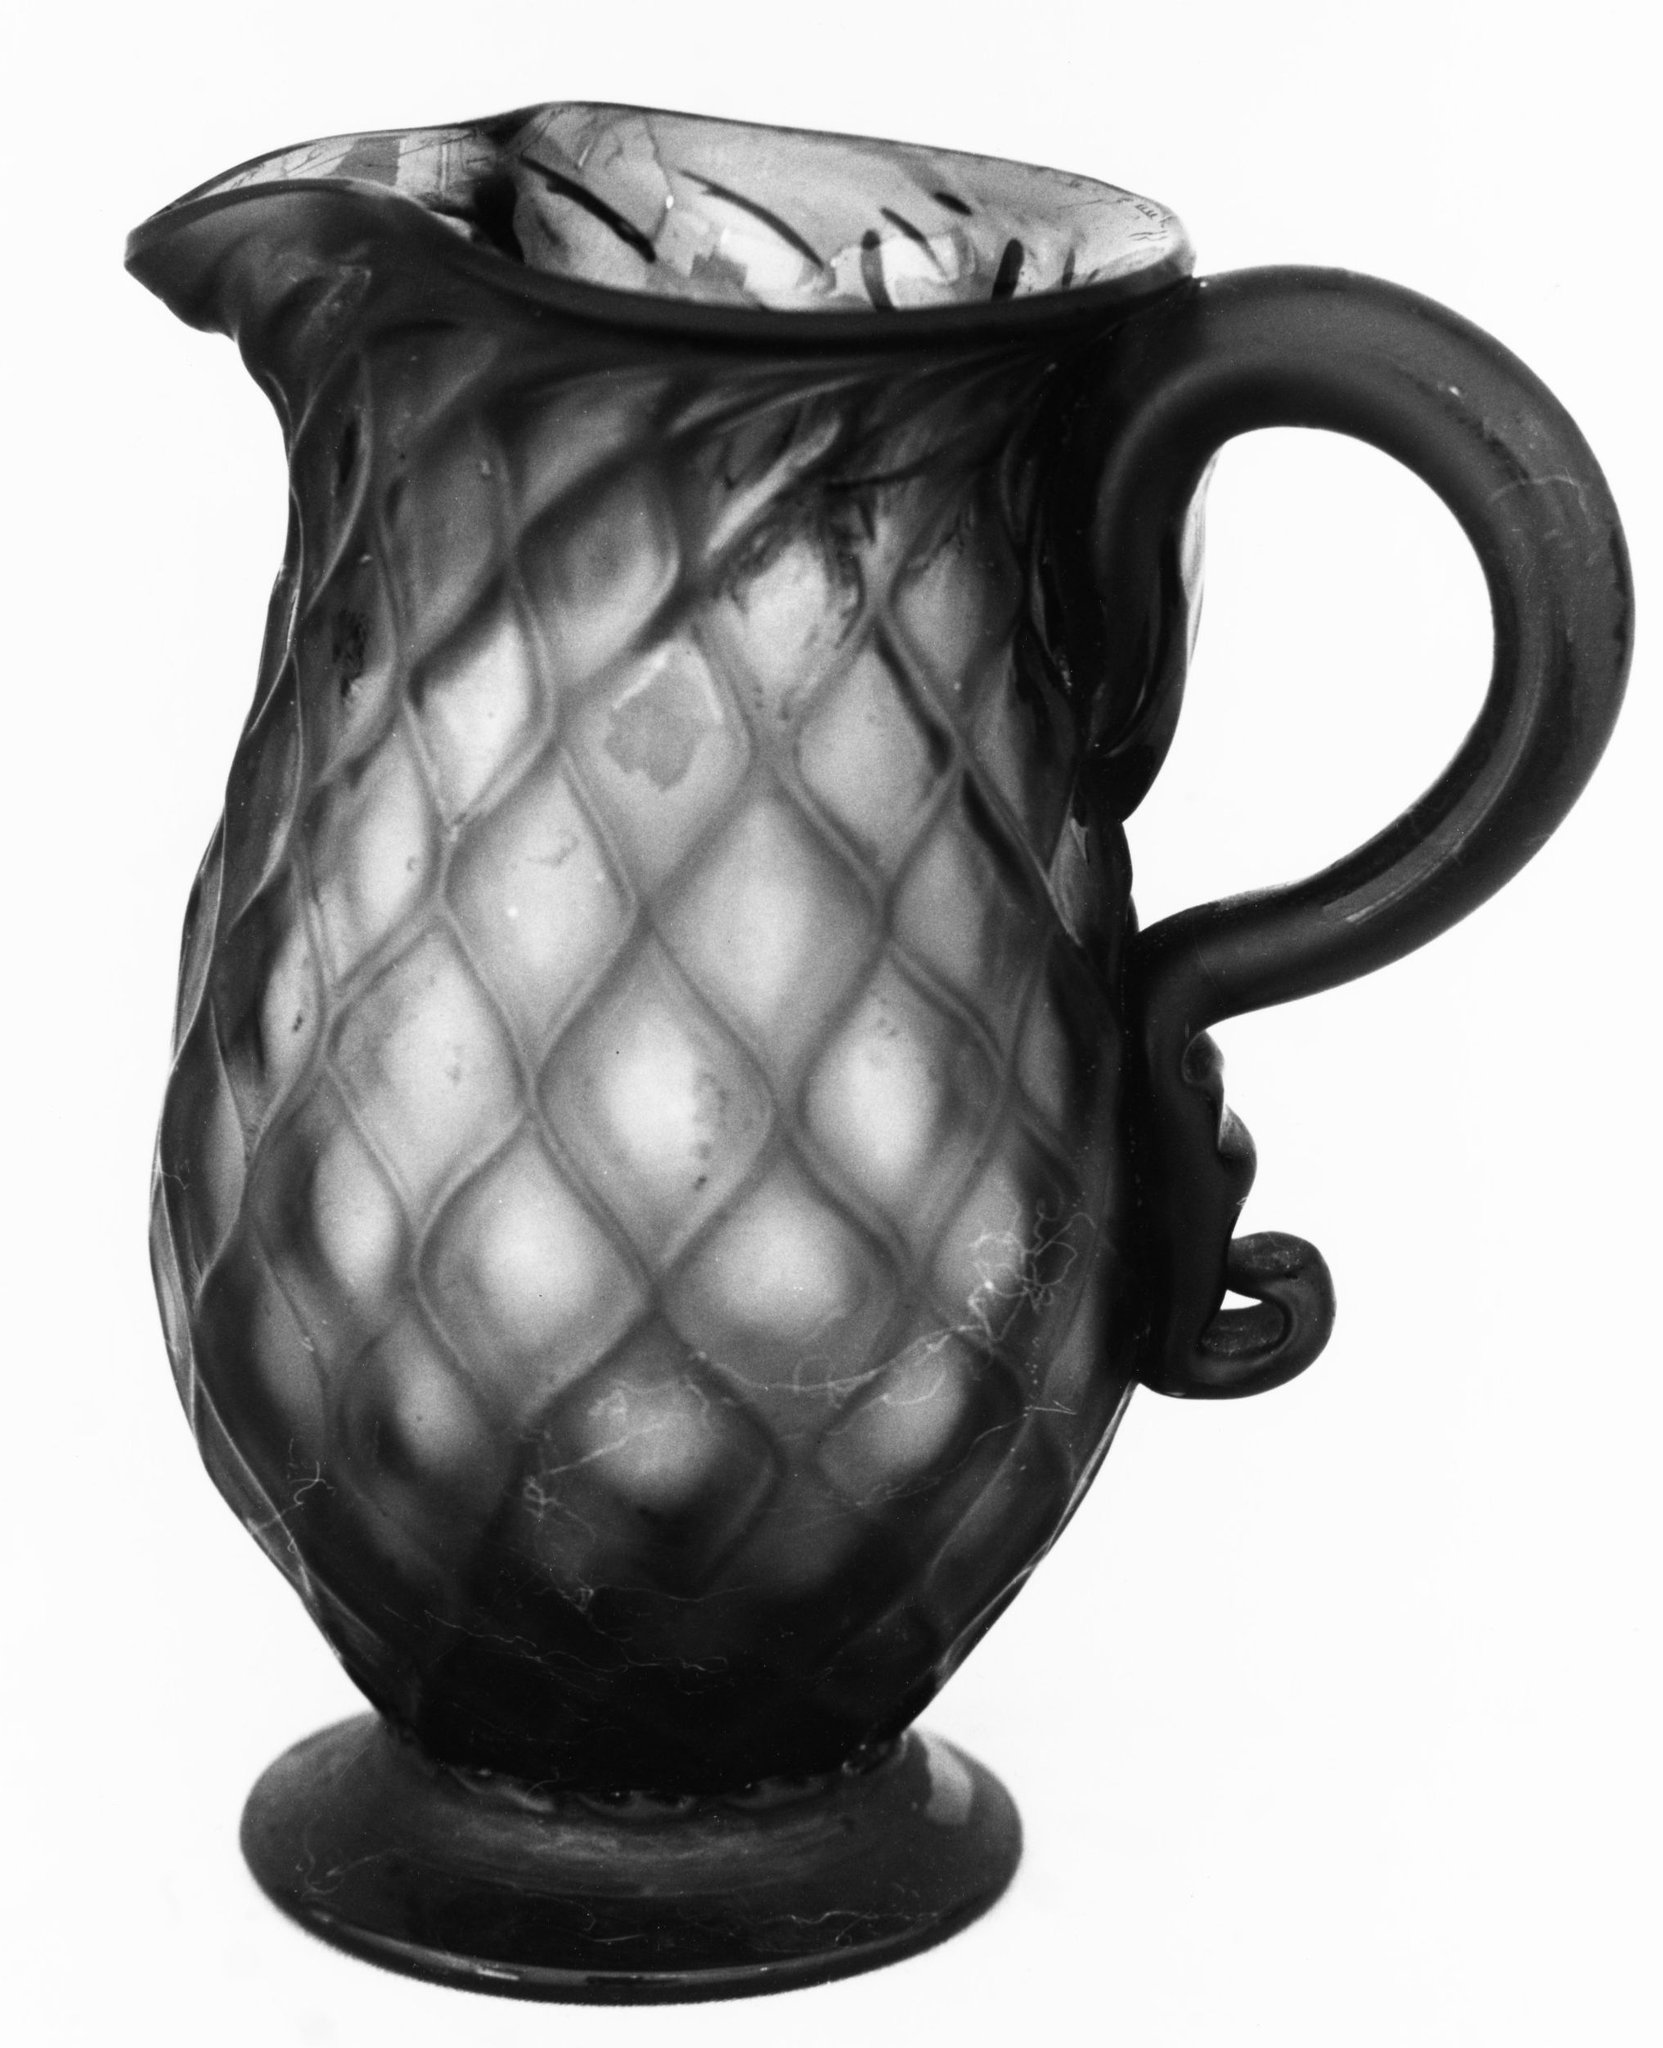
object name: cream pot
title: Creamer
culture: american or british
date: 1780-1820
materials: glass, lead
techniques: glassblowing, molding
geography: england